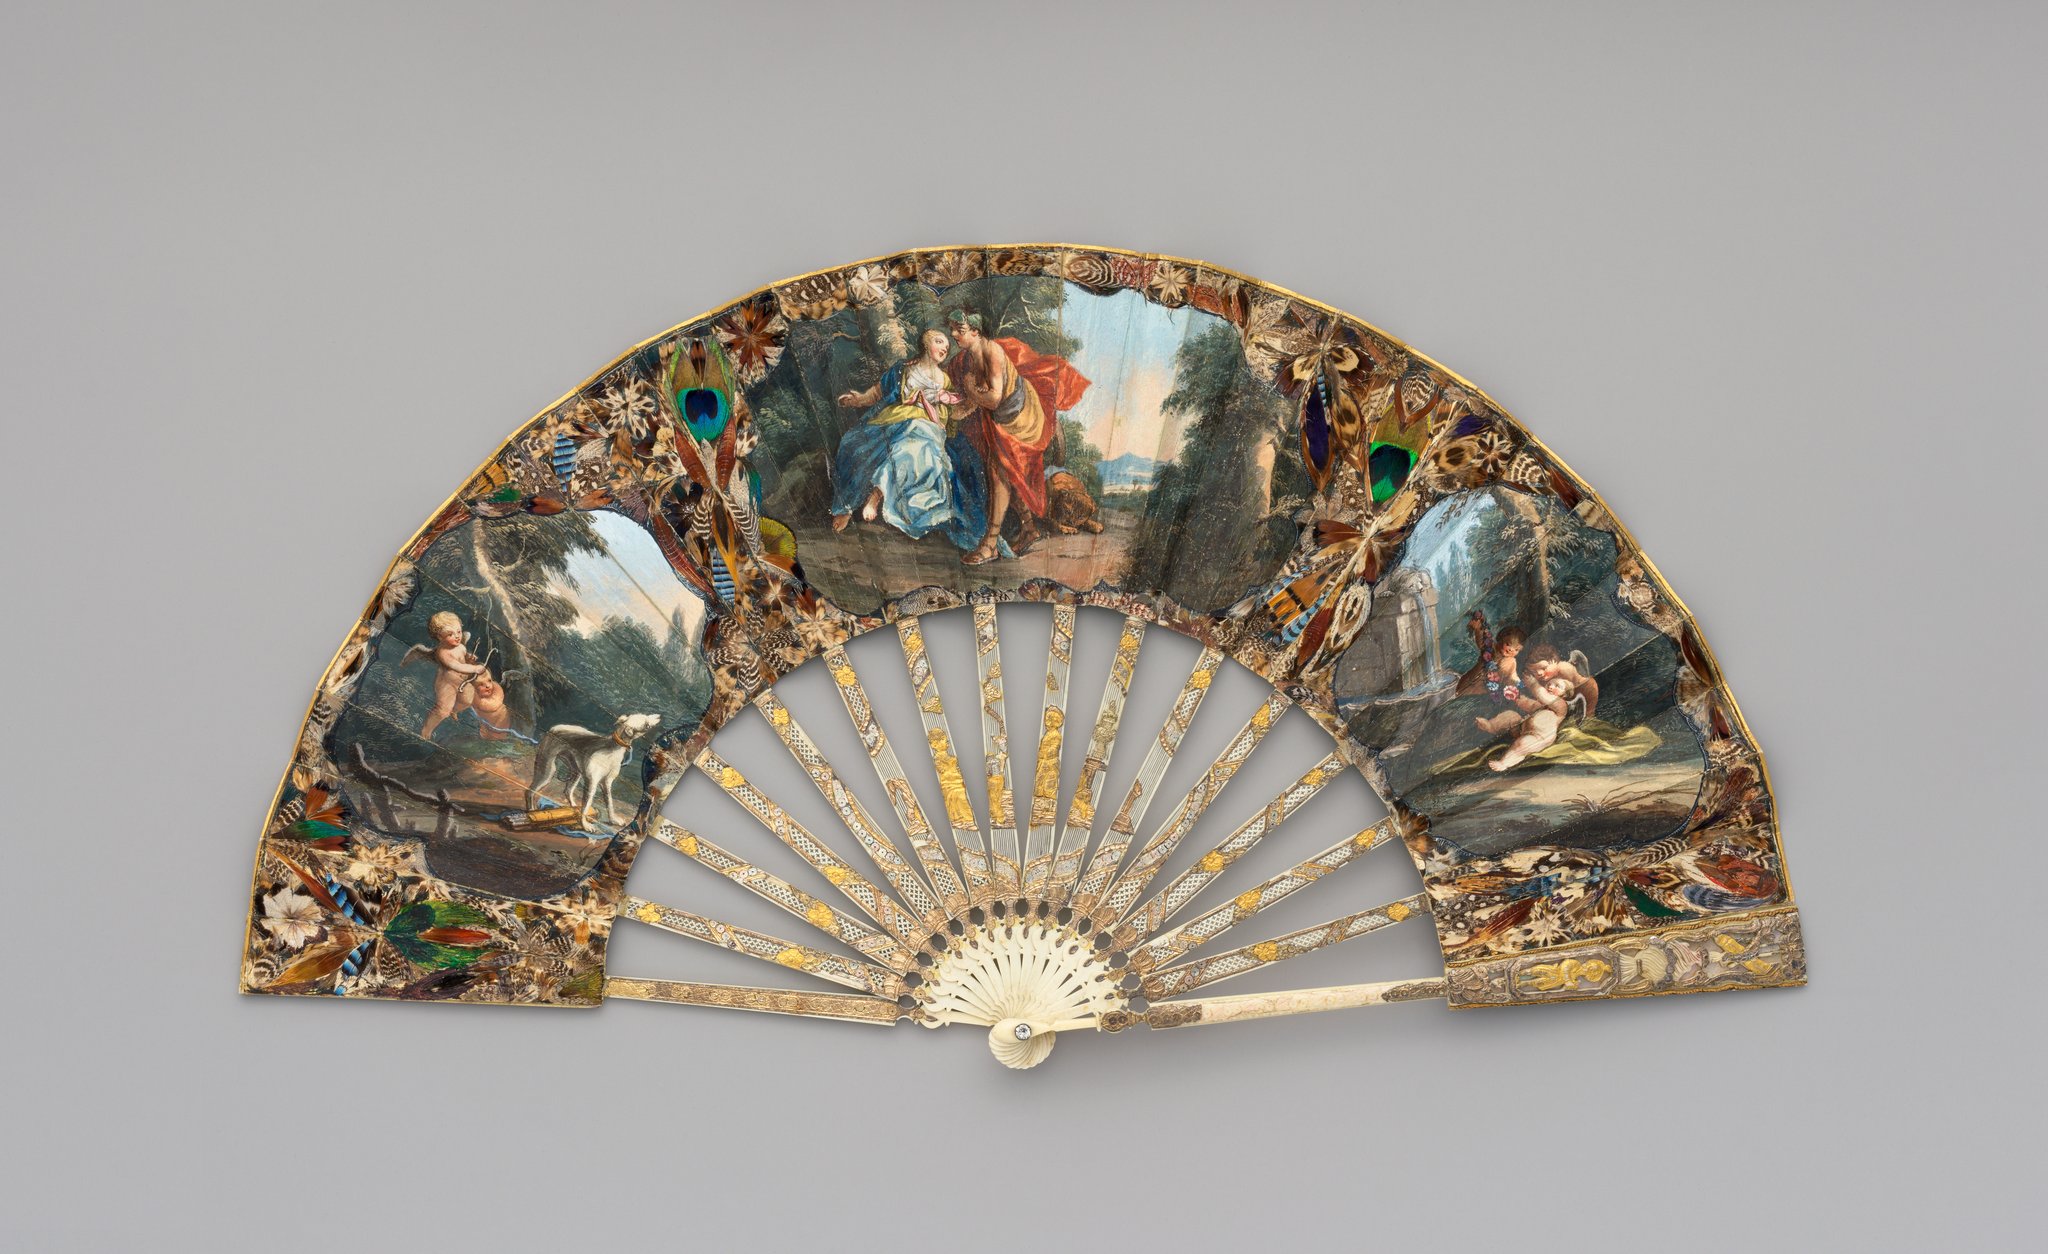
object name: fan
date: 1701-1800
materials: feather, glass, ivory, paper, silk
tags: men,women,putti,dogs,butterflies